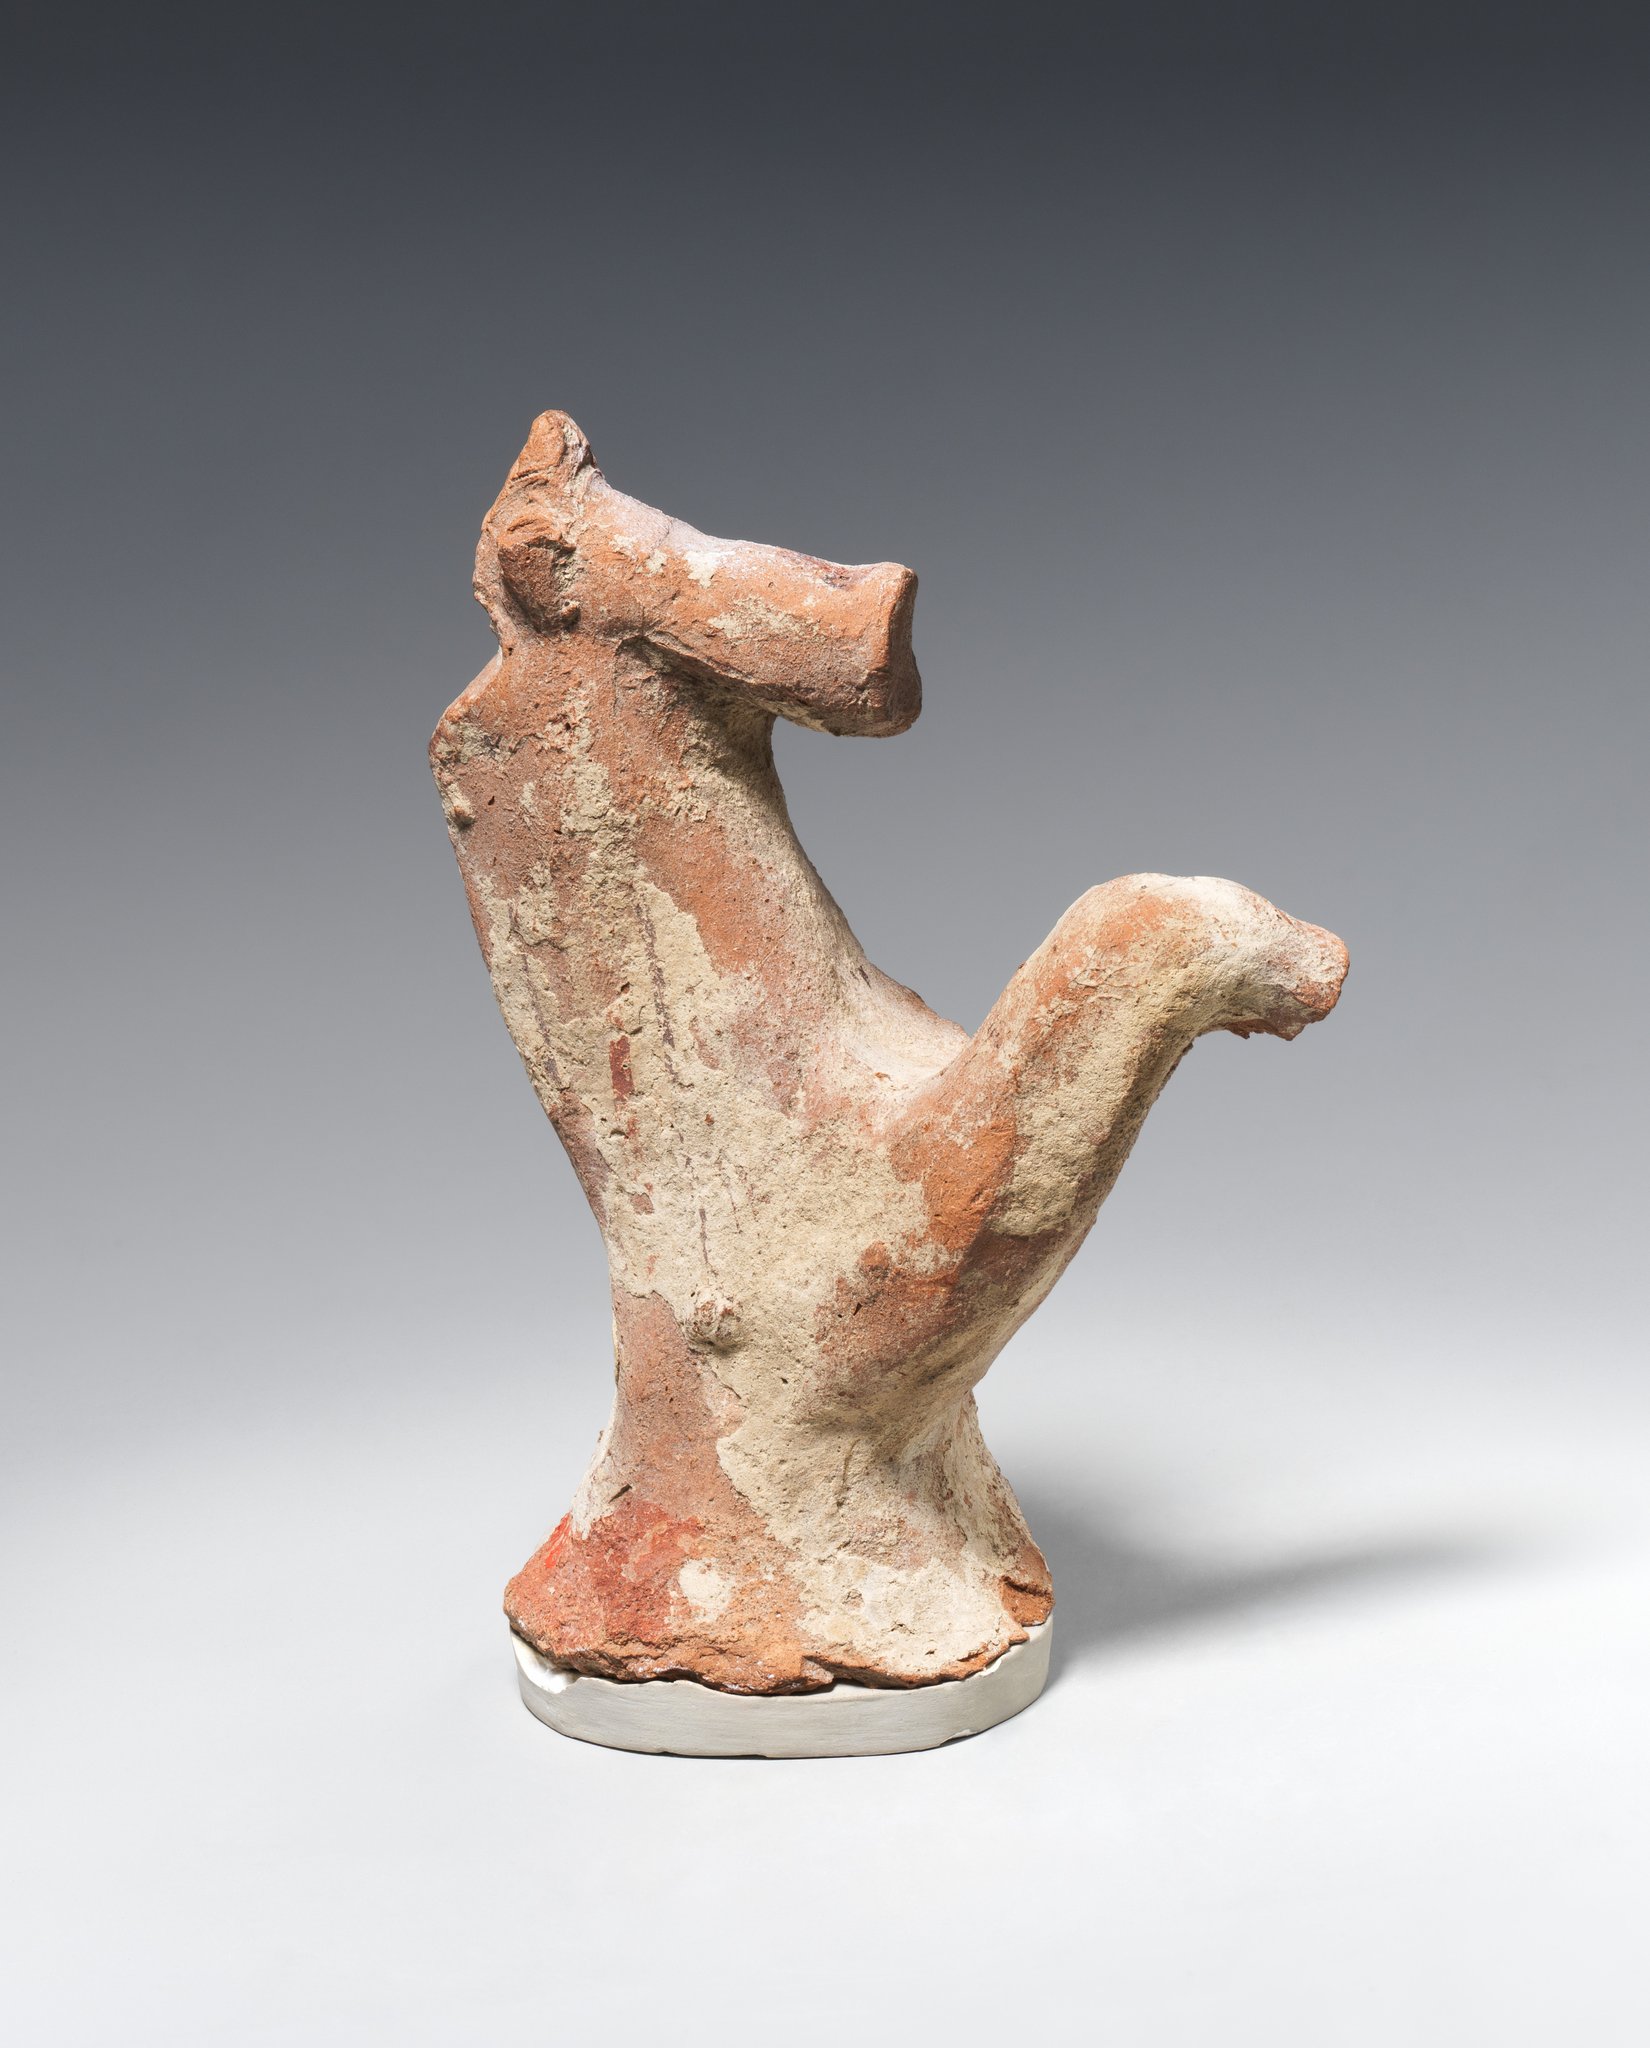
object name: figurine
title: Horse Figure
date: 306-30 BCE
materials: pottery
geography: egypt